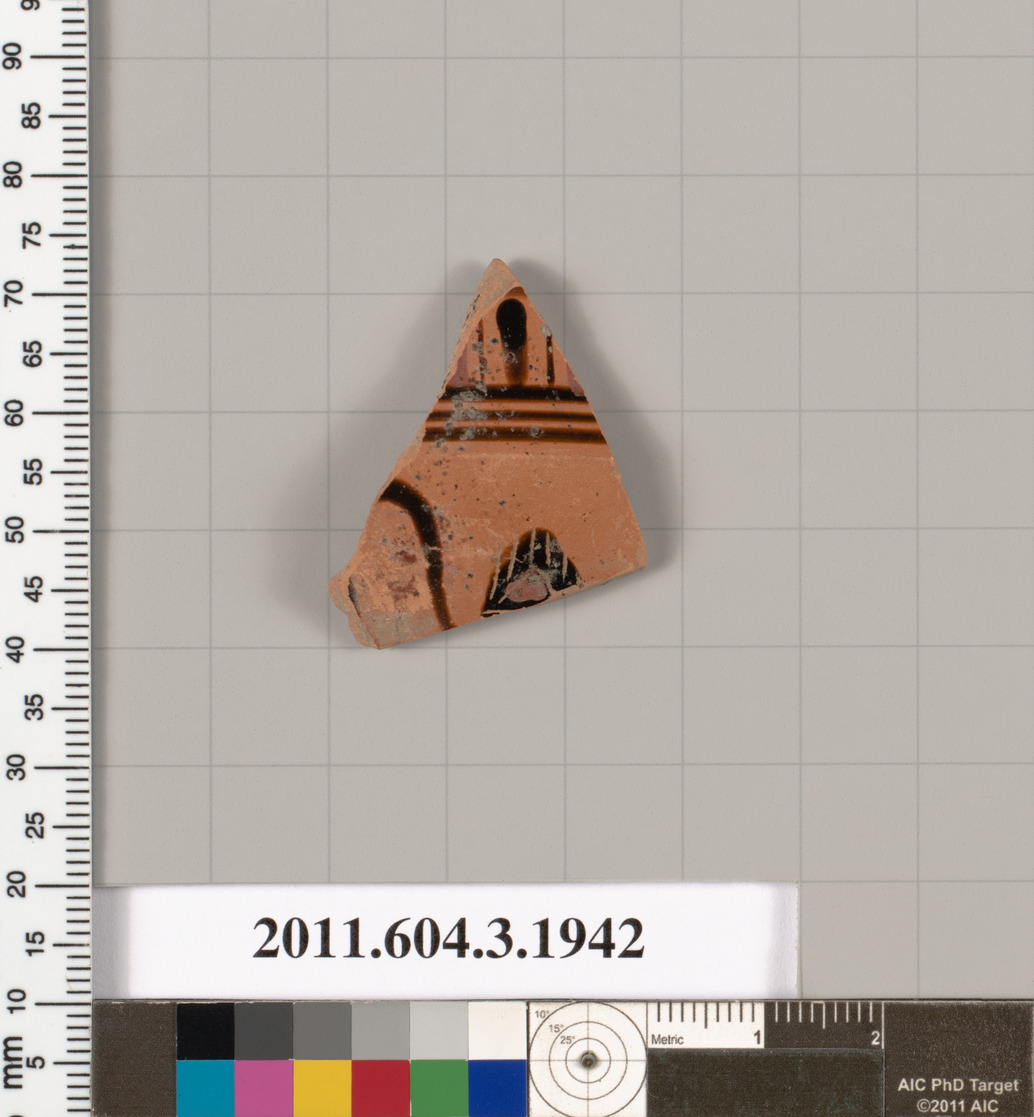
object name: kylix fragment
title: Terracotta fragment of a kylix: Cassel cup (drinking cup)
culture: greek, attic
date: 550-526 BCE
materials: terracotta